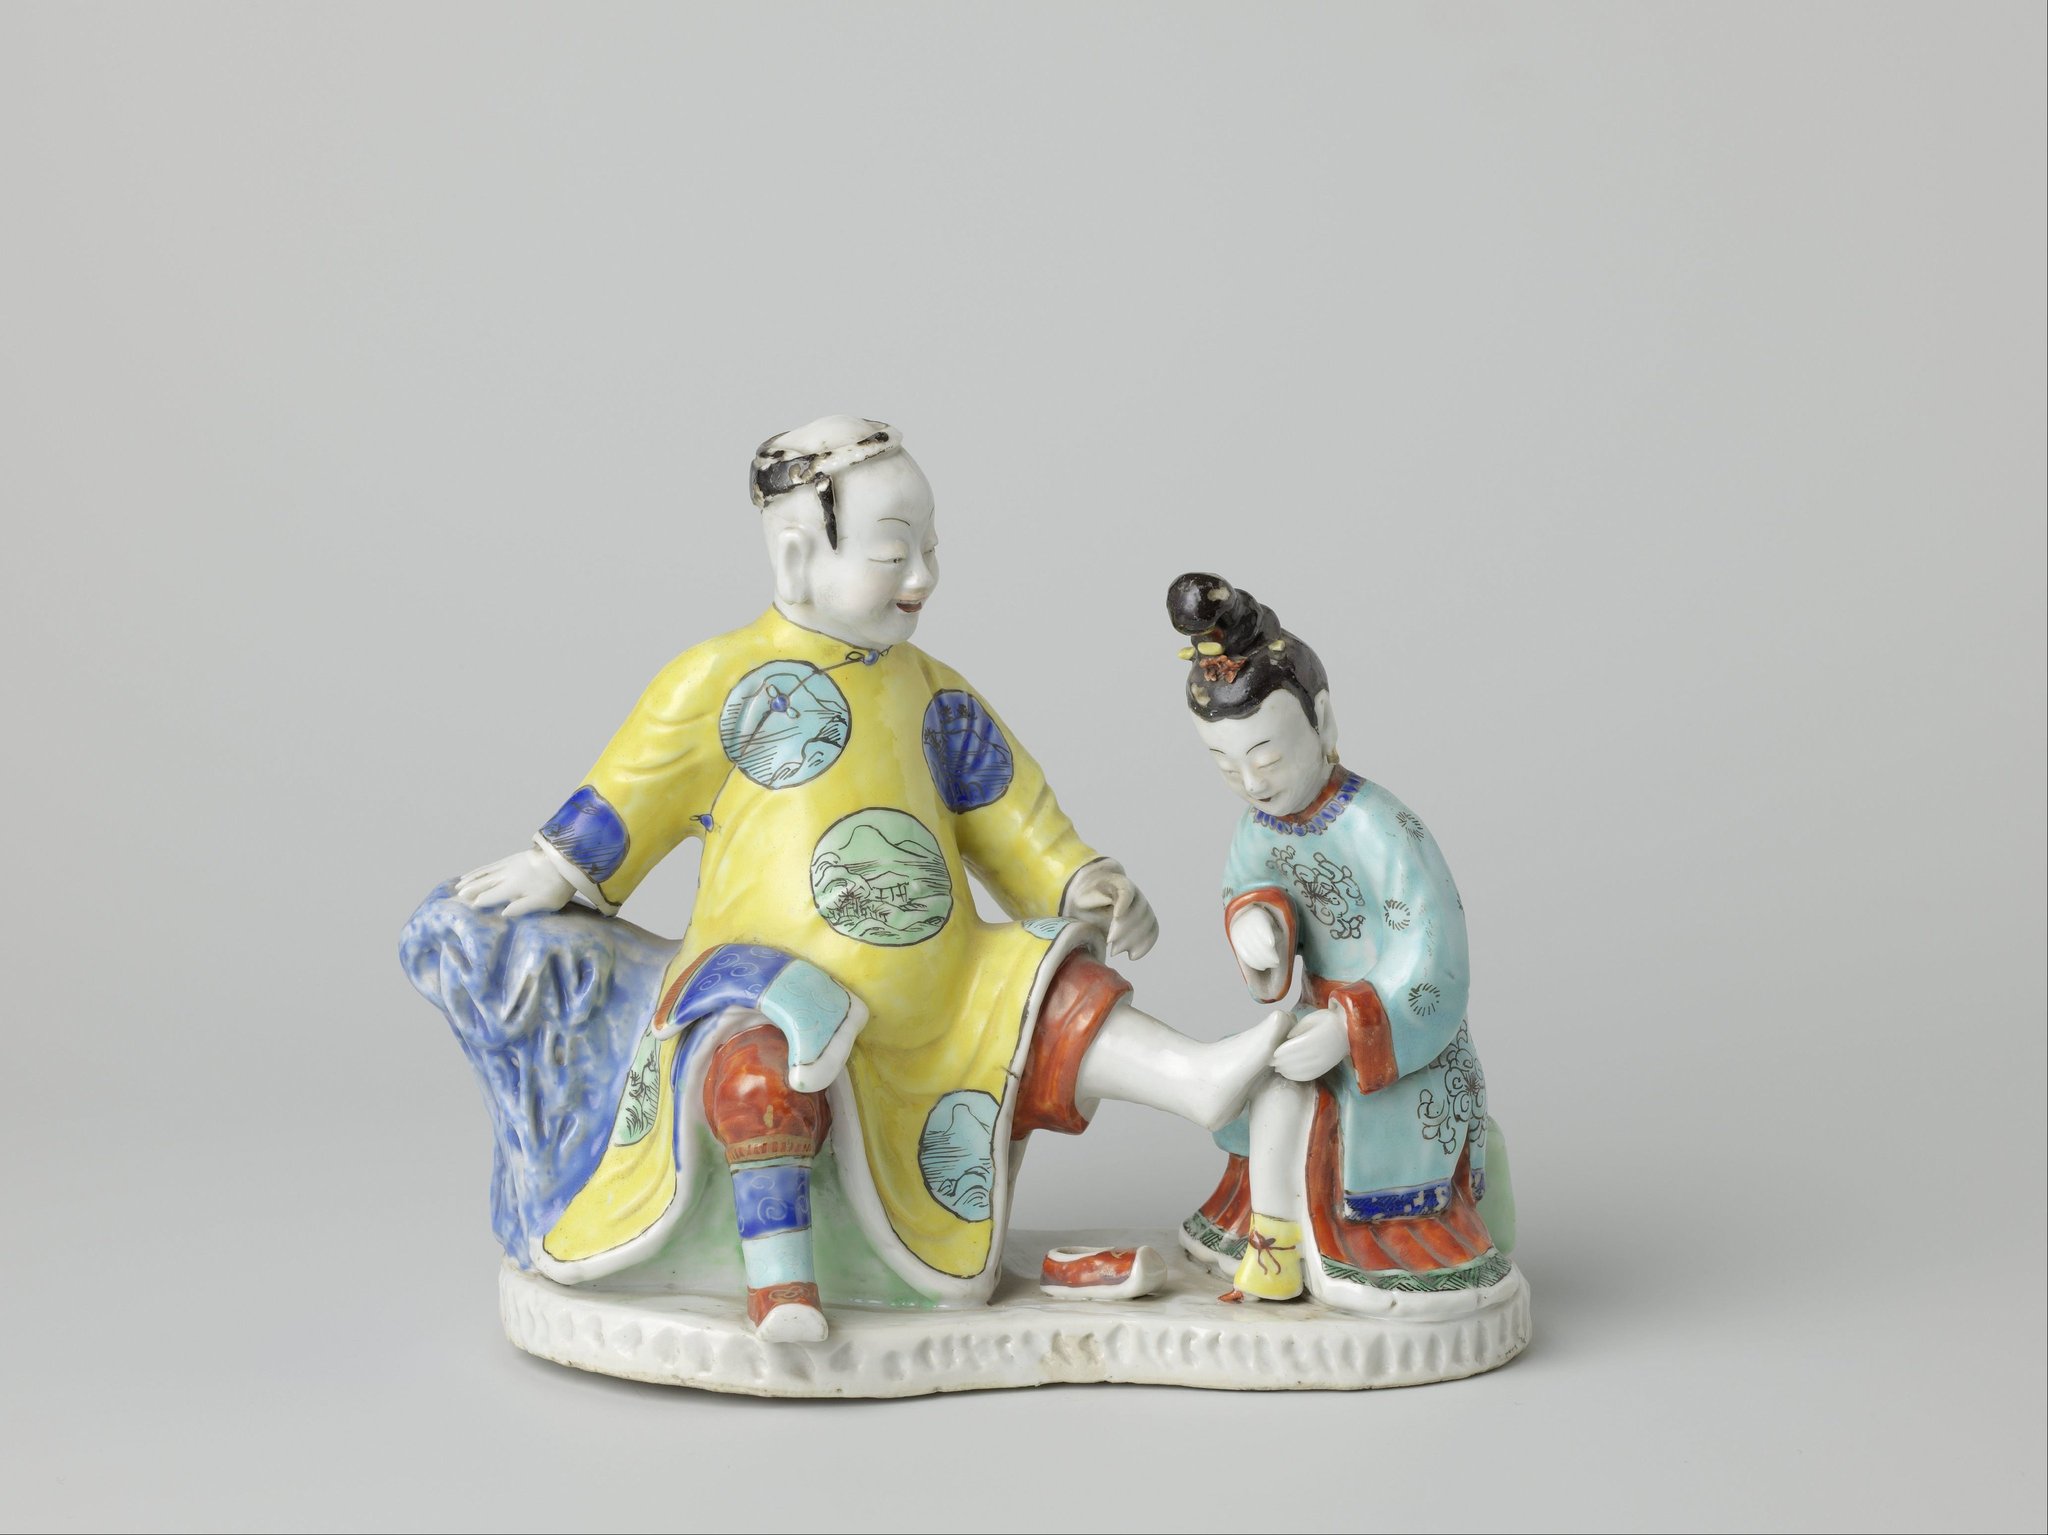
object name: figure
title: Figure of a Chinese couple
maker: Anonymous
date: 1750-1770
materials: glaze, gold, paint, porcelain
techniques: firing, forming, gilding, vitrification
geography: china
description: Beeld van een Chinees paar van porselein op een voetstuk, beschilderd op het glazuur in blauw, turquoise, rood, groen, geel, zwart en goud. De man zit op een rots, de vrouw op een kruk naast hem. Hij heeft zijn linkerschoen uitgetrokken, die ligt tussen het stel op de grond. Zijn sok ligt op zijn rechterbeen. De man steunt met zijn blote voet op het linkerbeen van de vrouw. Haar jurk is opgetrokken tot boven de knie, waardoor haar ingebonden voet zichtbaar is. Porselein met emailkleuren.